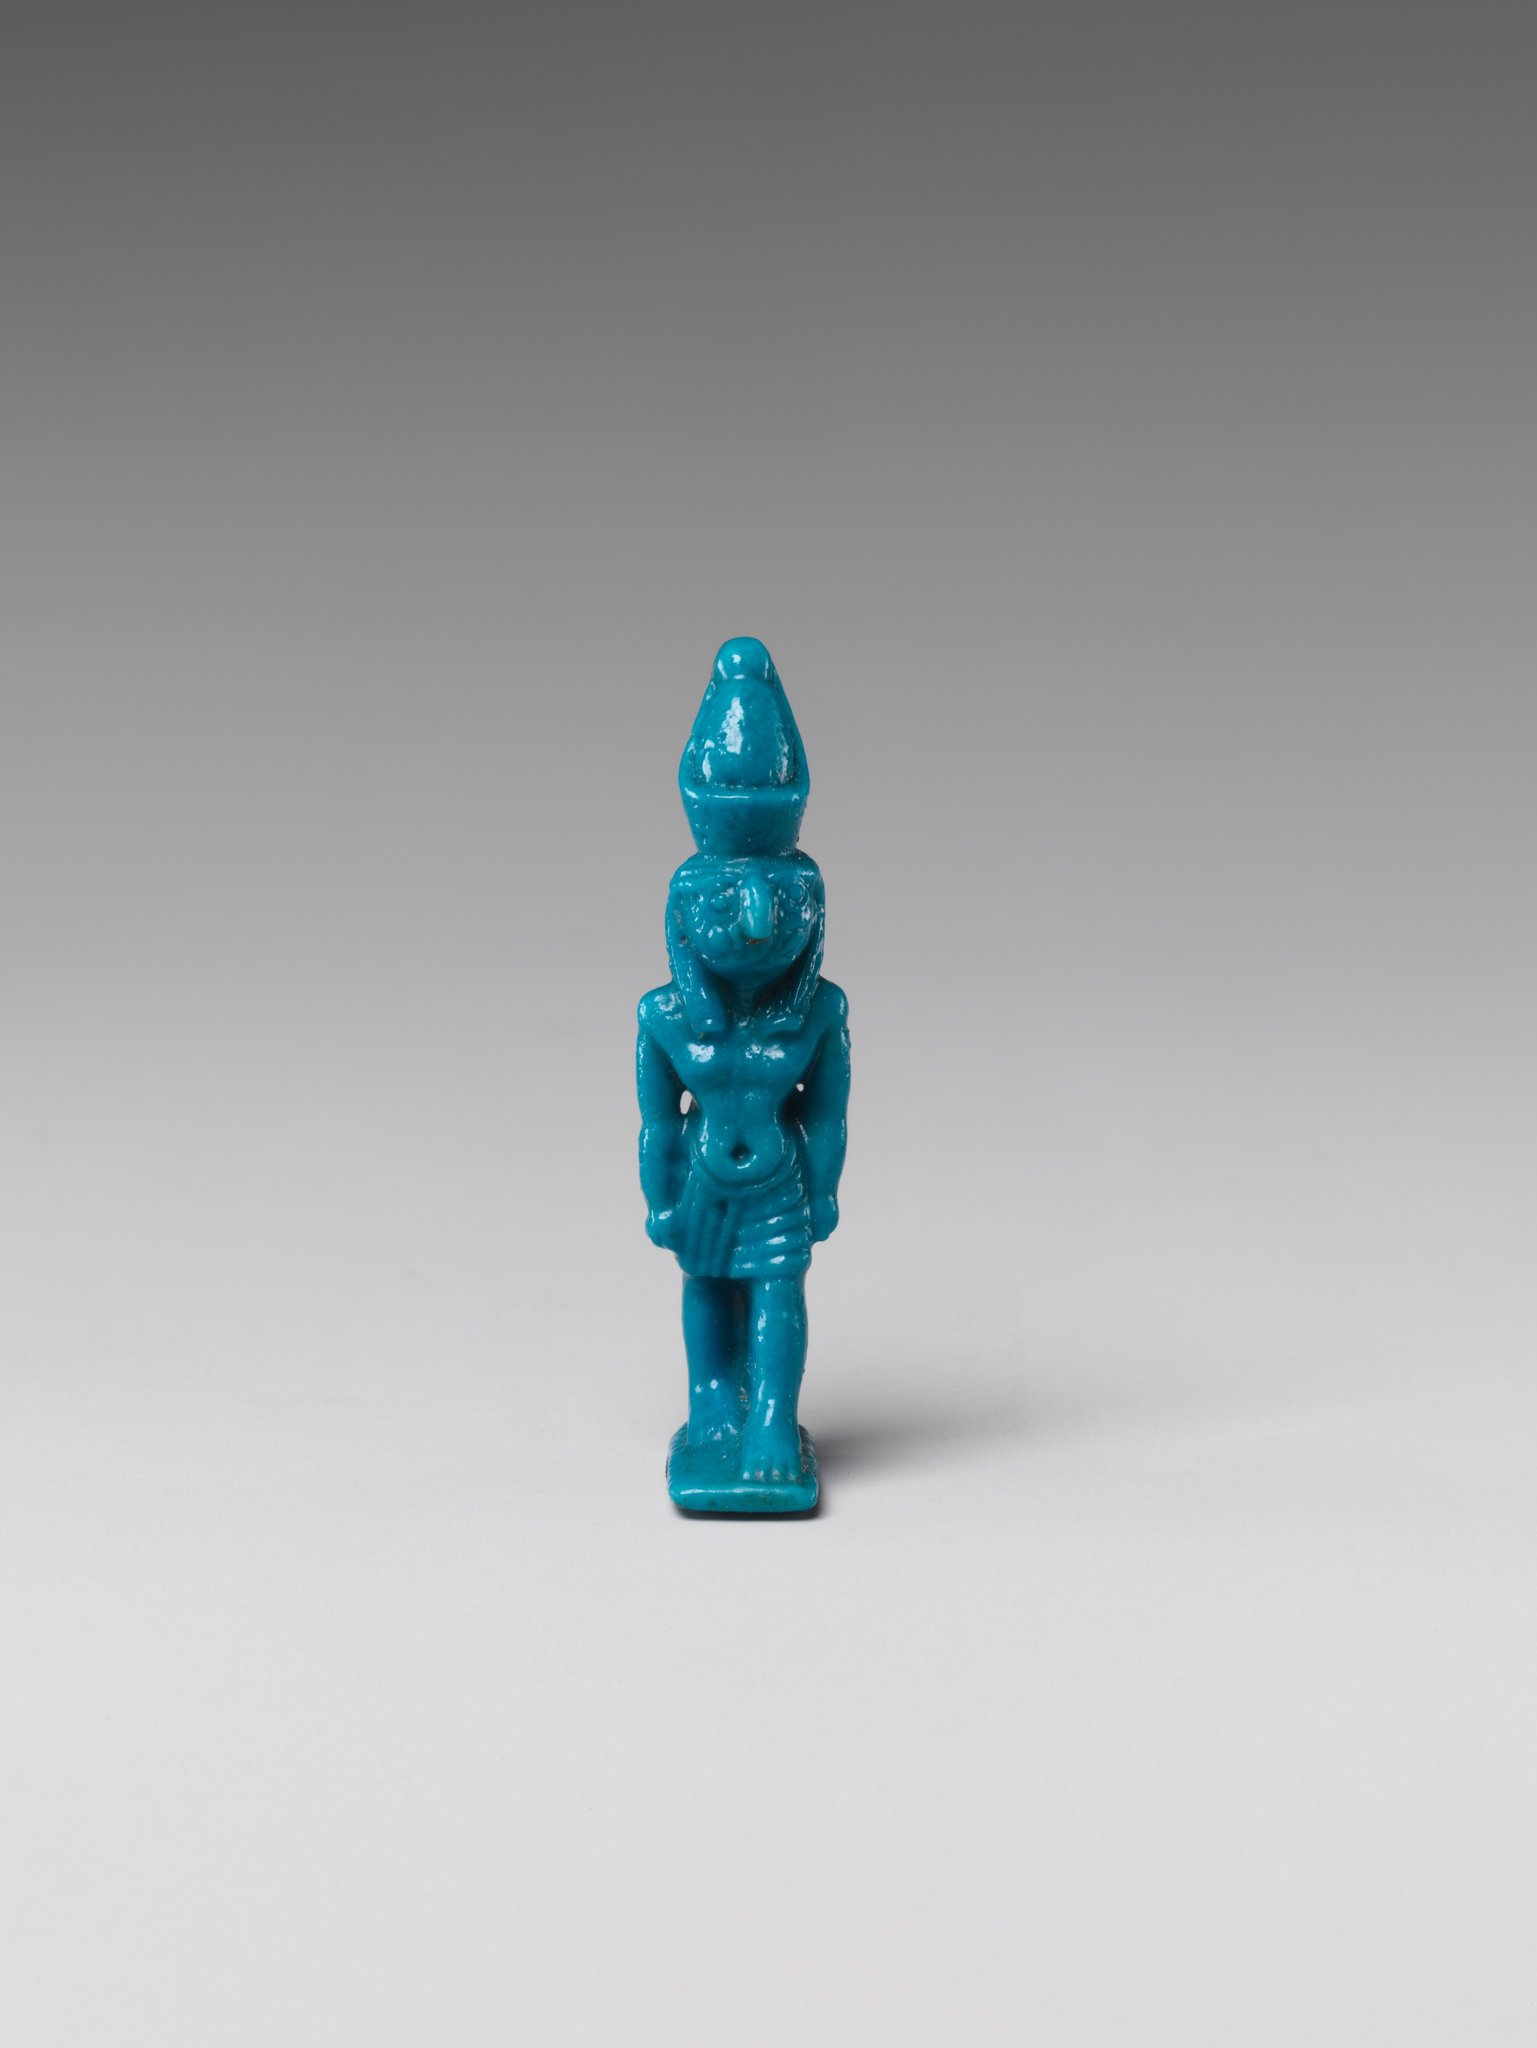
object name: necklace, bead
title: Horus amulet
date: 332-330 BCE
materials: faience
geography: egypt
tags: horus